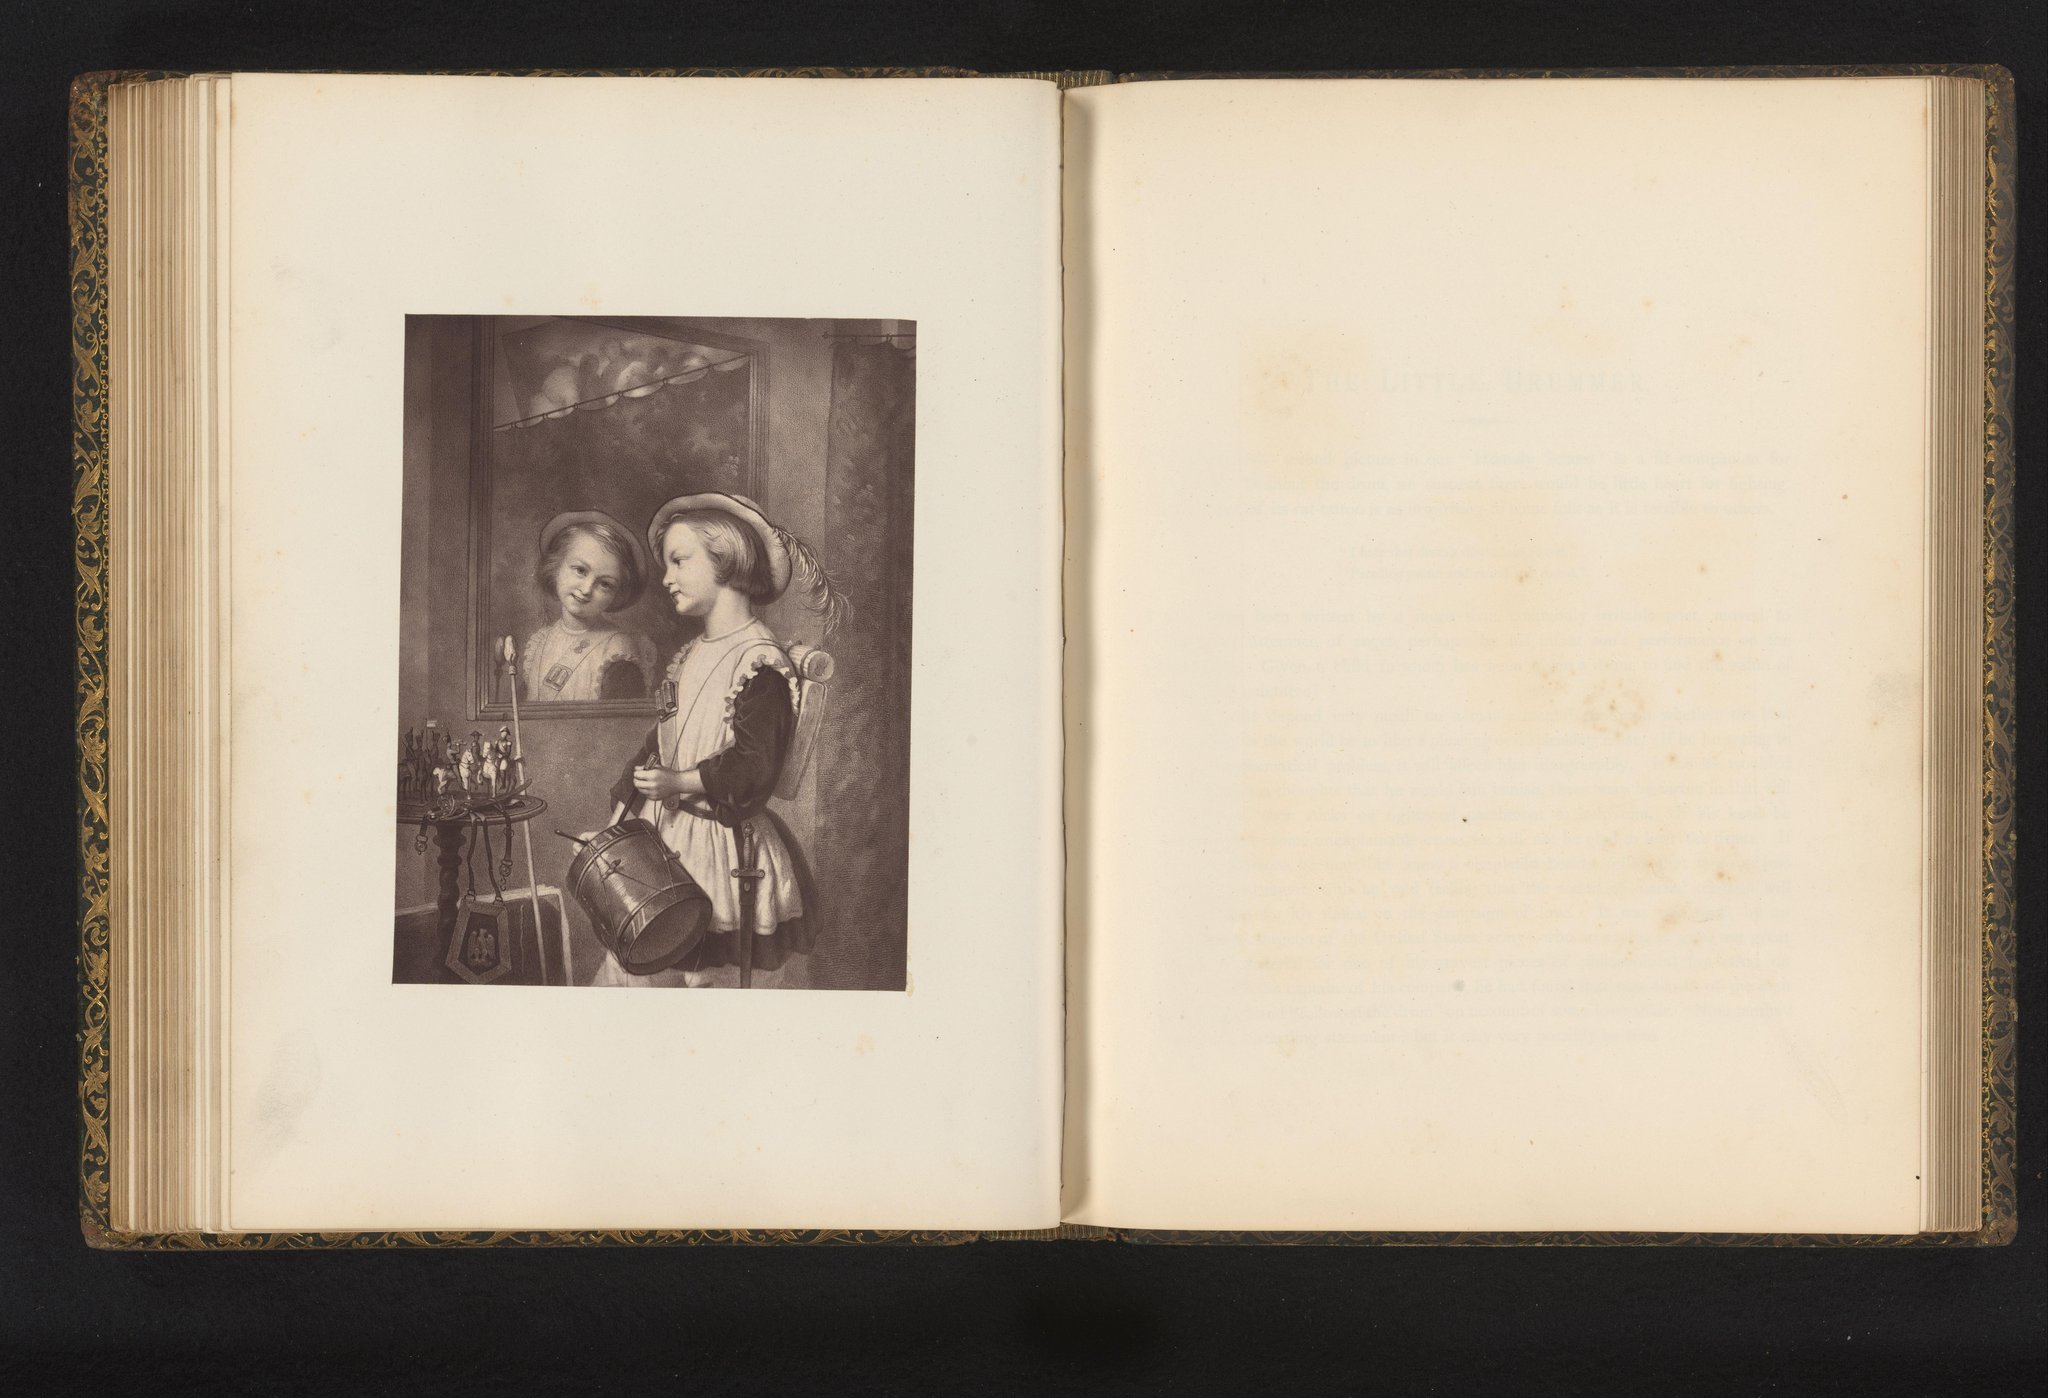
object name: photomechanical print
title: Fotoreproductie van een prent naar het schilderij The little drummer door Adolphe Dubasty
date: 1866-1871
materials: paper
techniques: woodburytype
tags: print, e.g.: engraving, etching, lithograph, drum (musical instrument), reflection (in a mirror), child (at home)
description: Prent op tweede ongenummerde pagina na pagina 86.